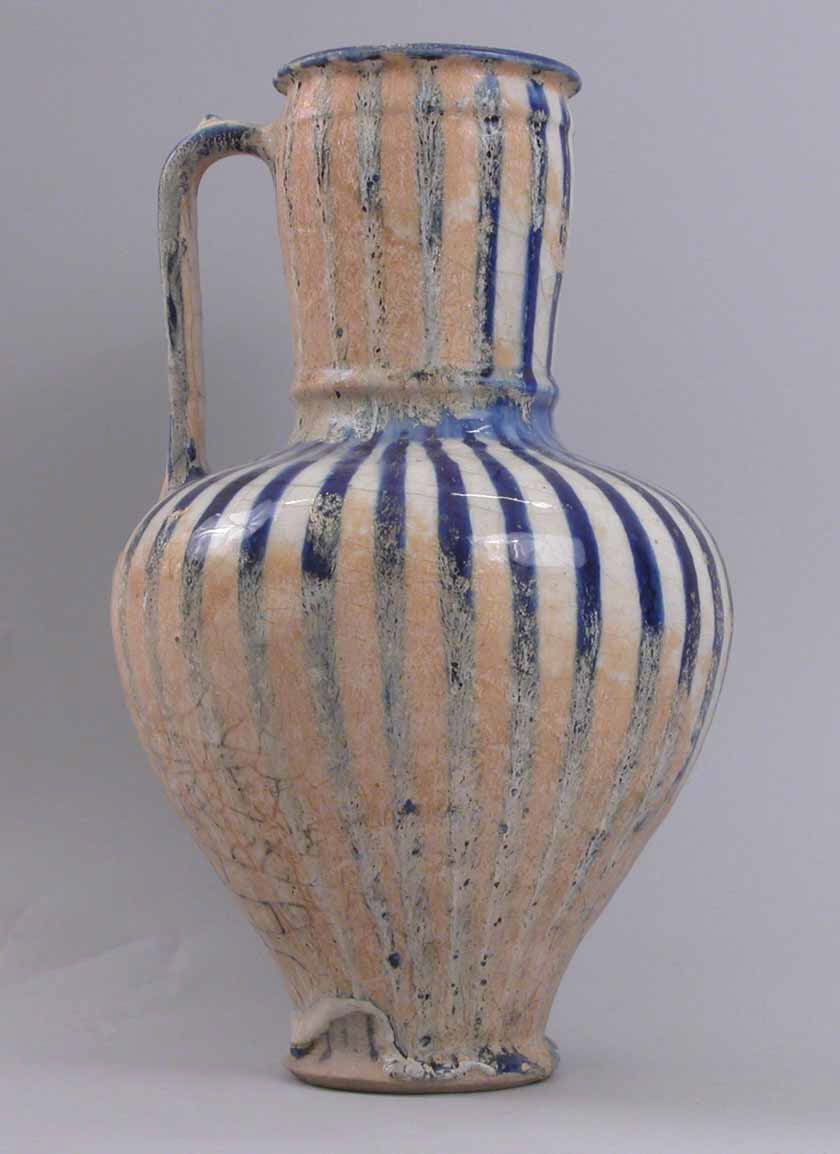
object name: ewer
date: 1101-1300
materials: stonepaste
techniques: glazing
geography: iran